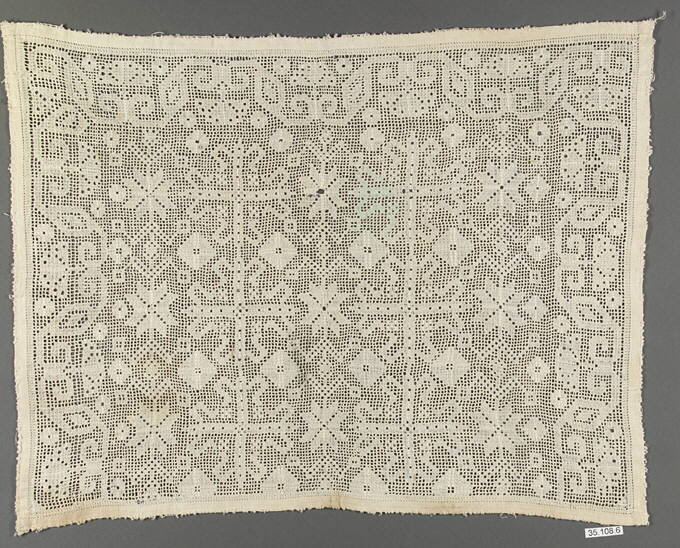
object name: panel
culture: mexican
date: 1801-1900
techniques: embroidery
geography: mexico